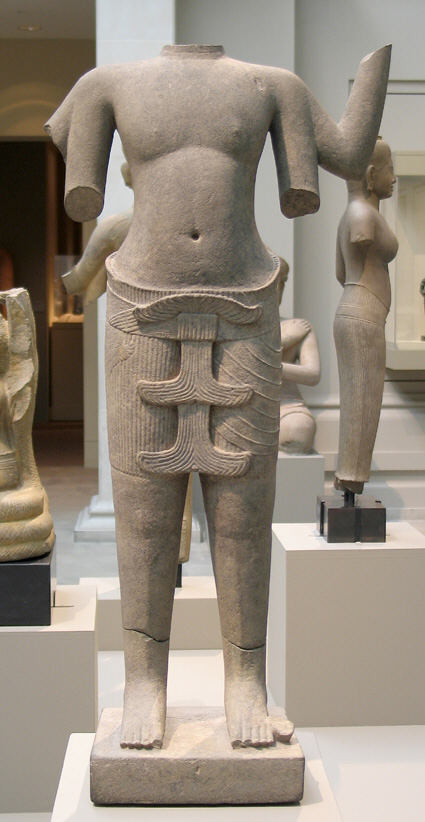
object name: figure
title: Standing Four-Armed Vishnu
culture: cambodian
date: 1101-1200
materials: stone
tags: vishnu